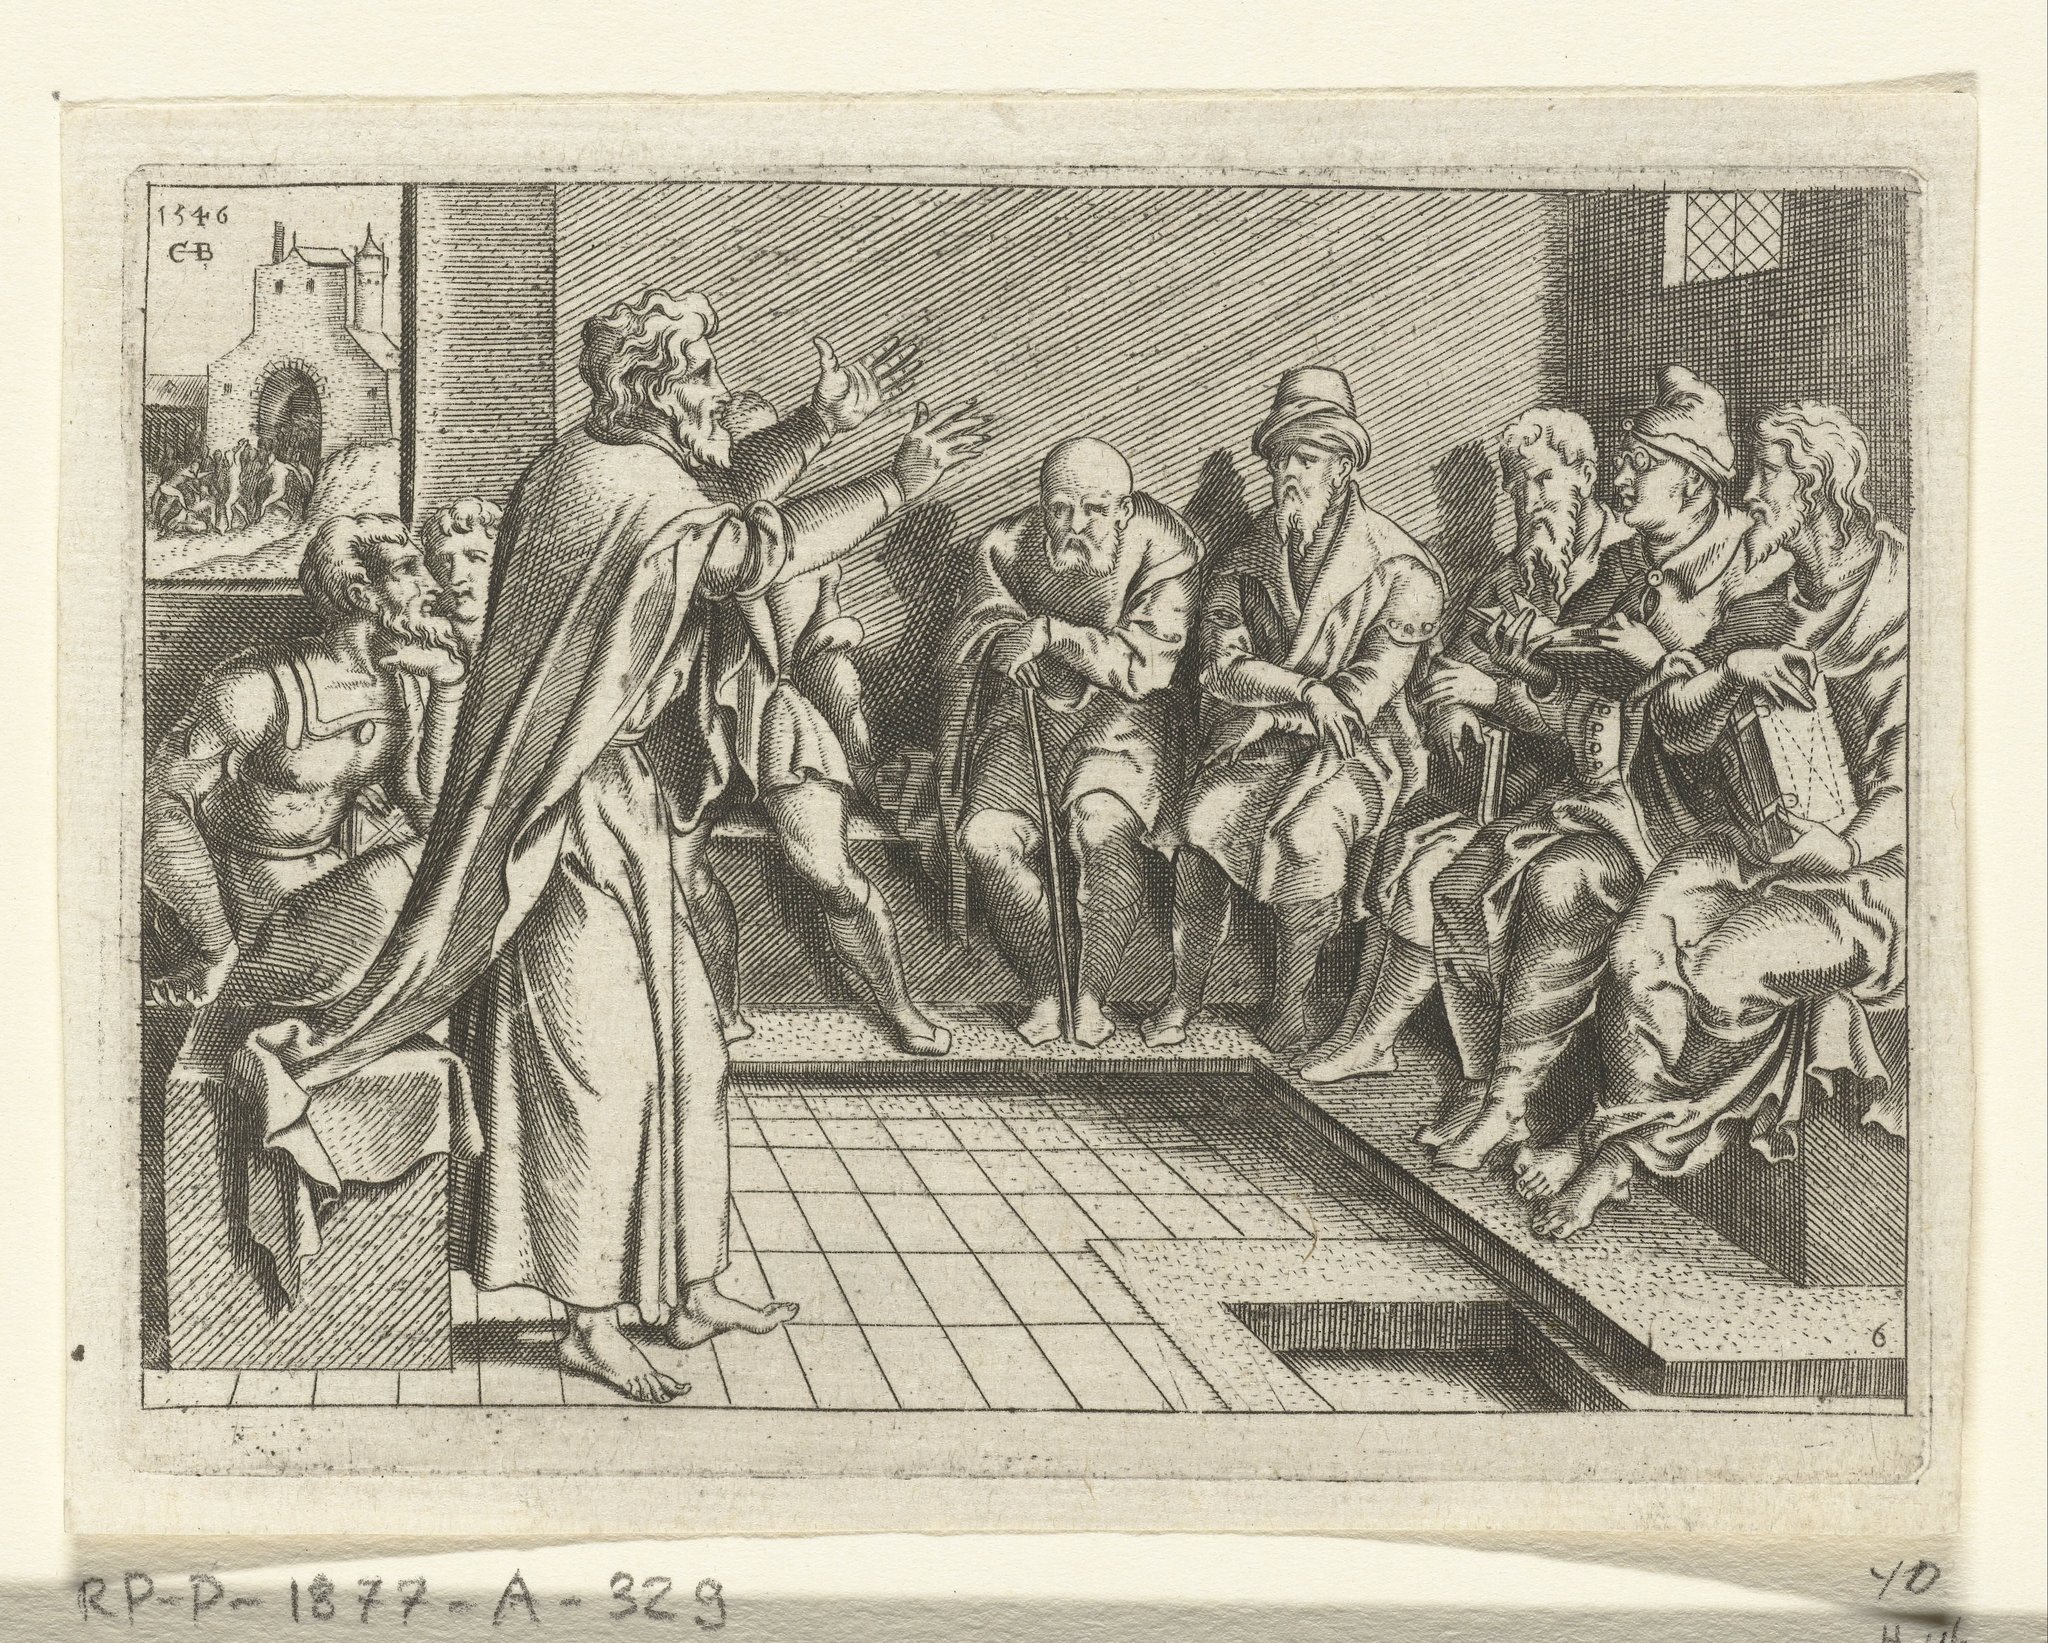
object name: print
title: Het leven van Paulus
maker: cornelis bos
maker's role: print maker, printer, publisher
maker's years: 1510-1566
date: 1546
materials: paper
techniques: engraving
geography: groningen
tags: paul preaches in the synagogue of damascus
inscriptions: collector's mark: Lugt 2228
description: Na zijn bekering en zijn doop preekt Paulus in de synagogen van Damascus. De Joden in Damascus wantrouwen hem en willen hem gevangen nemen. Door een raam is te zien hoe iemand gestenigd wordt, waarschijnlijk Stefanus omdat dat gebeurde in het bijzijn van Paulus. Prent uit een serie van 10 prenten met scènes uit het leven van de apostel Paulus.